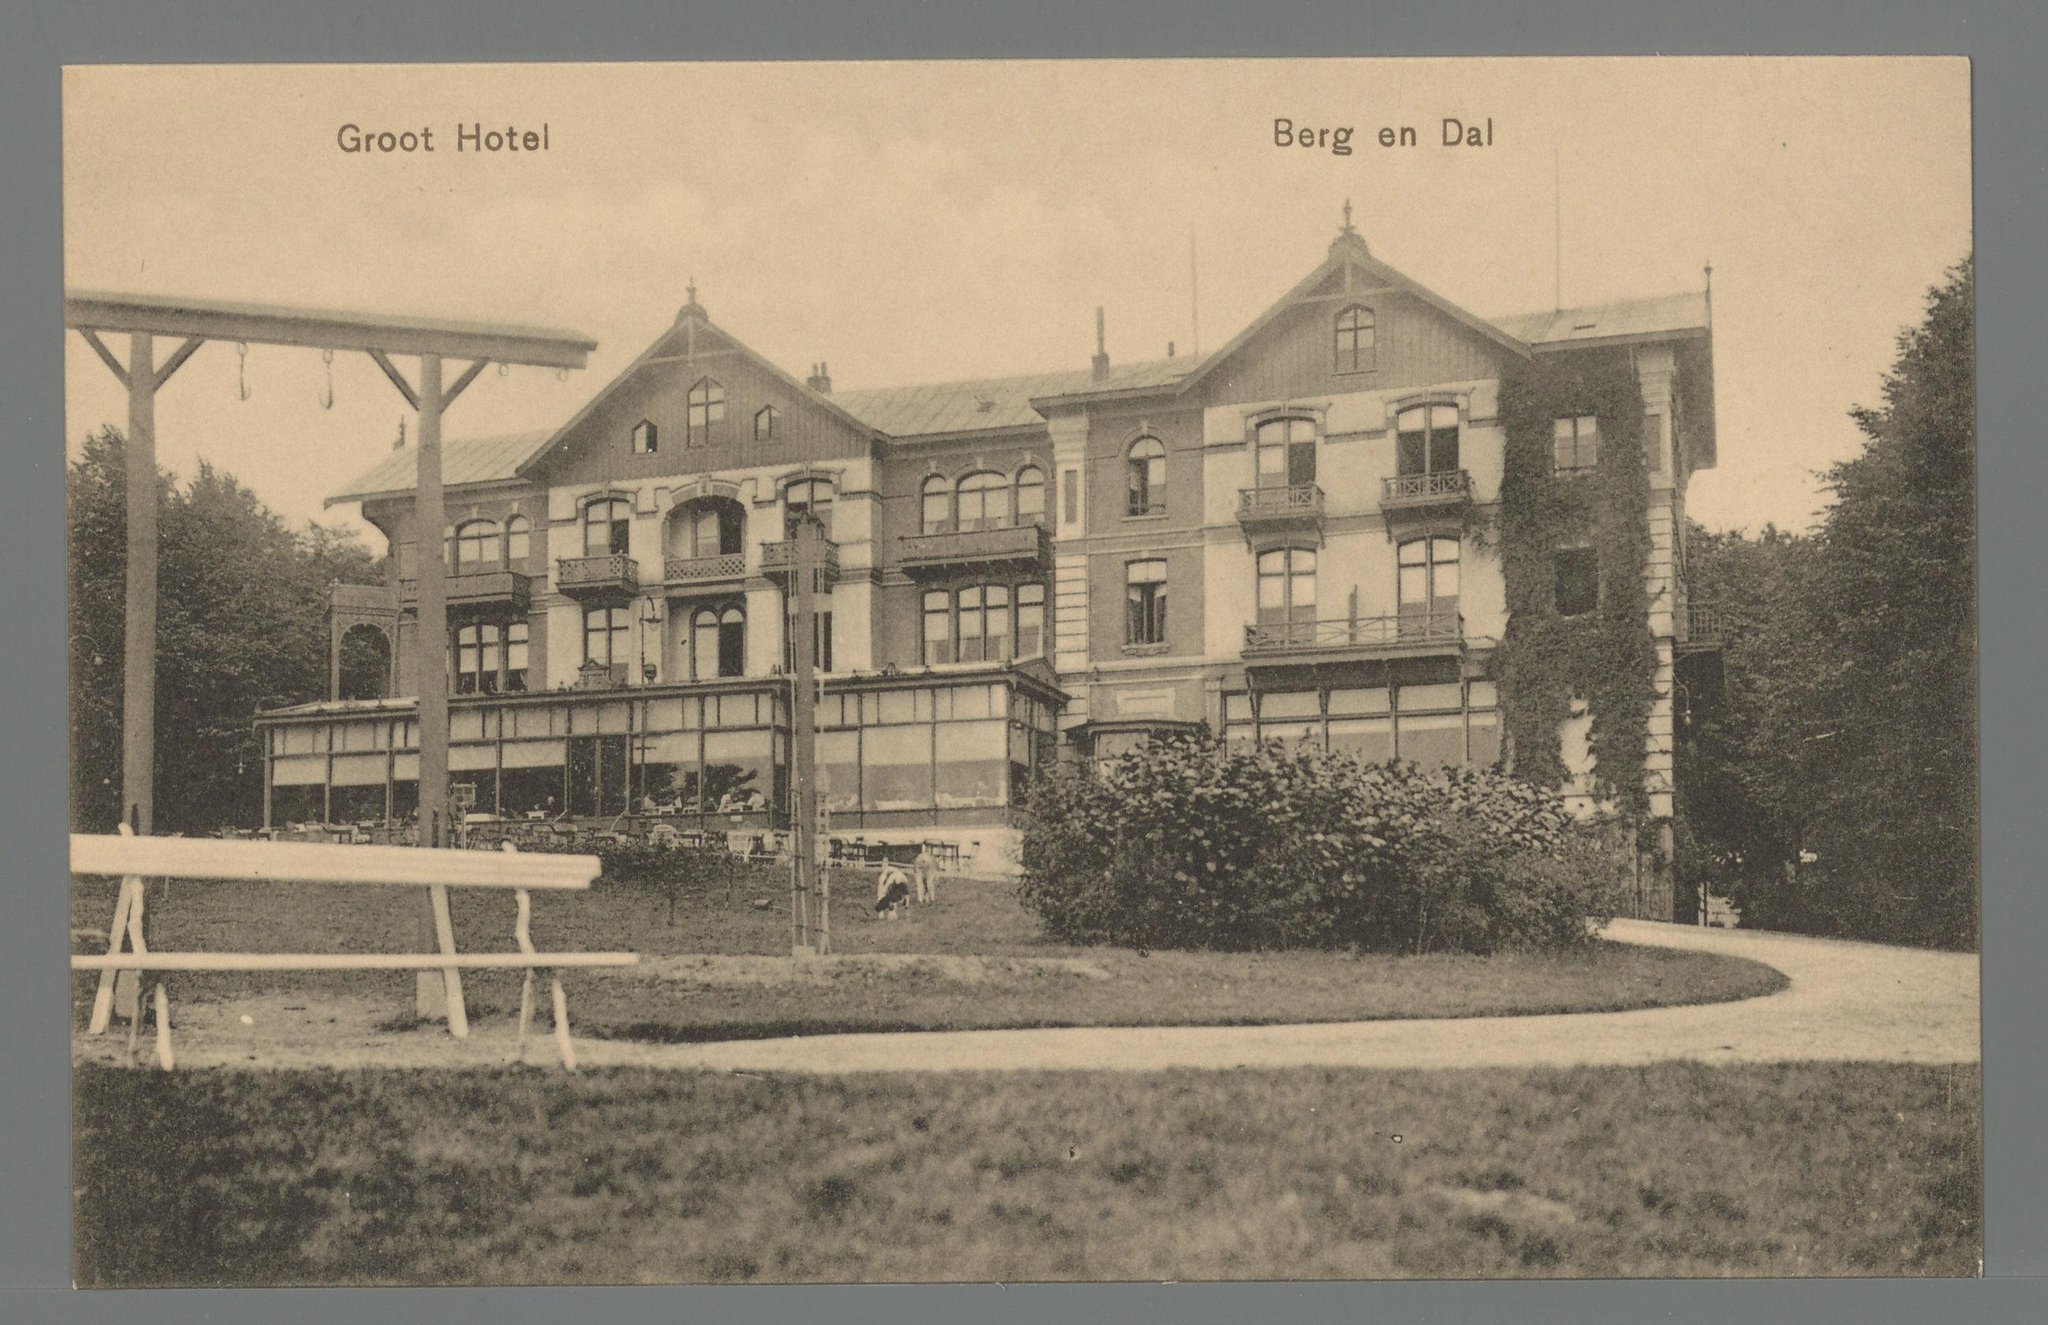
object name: photomechanical print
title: Groot Hotel. Berg en Dal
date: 1913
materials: cardboard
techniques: photograph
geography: plasmolen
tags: hotel, hostelry, inn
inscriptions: date